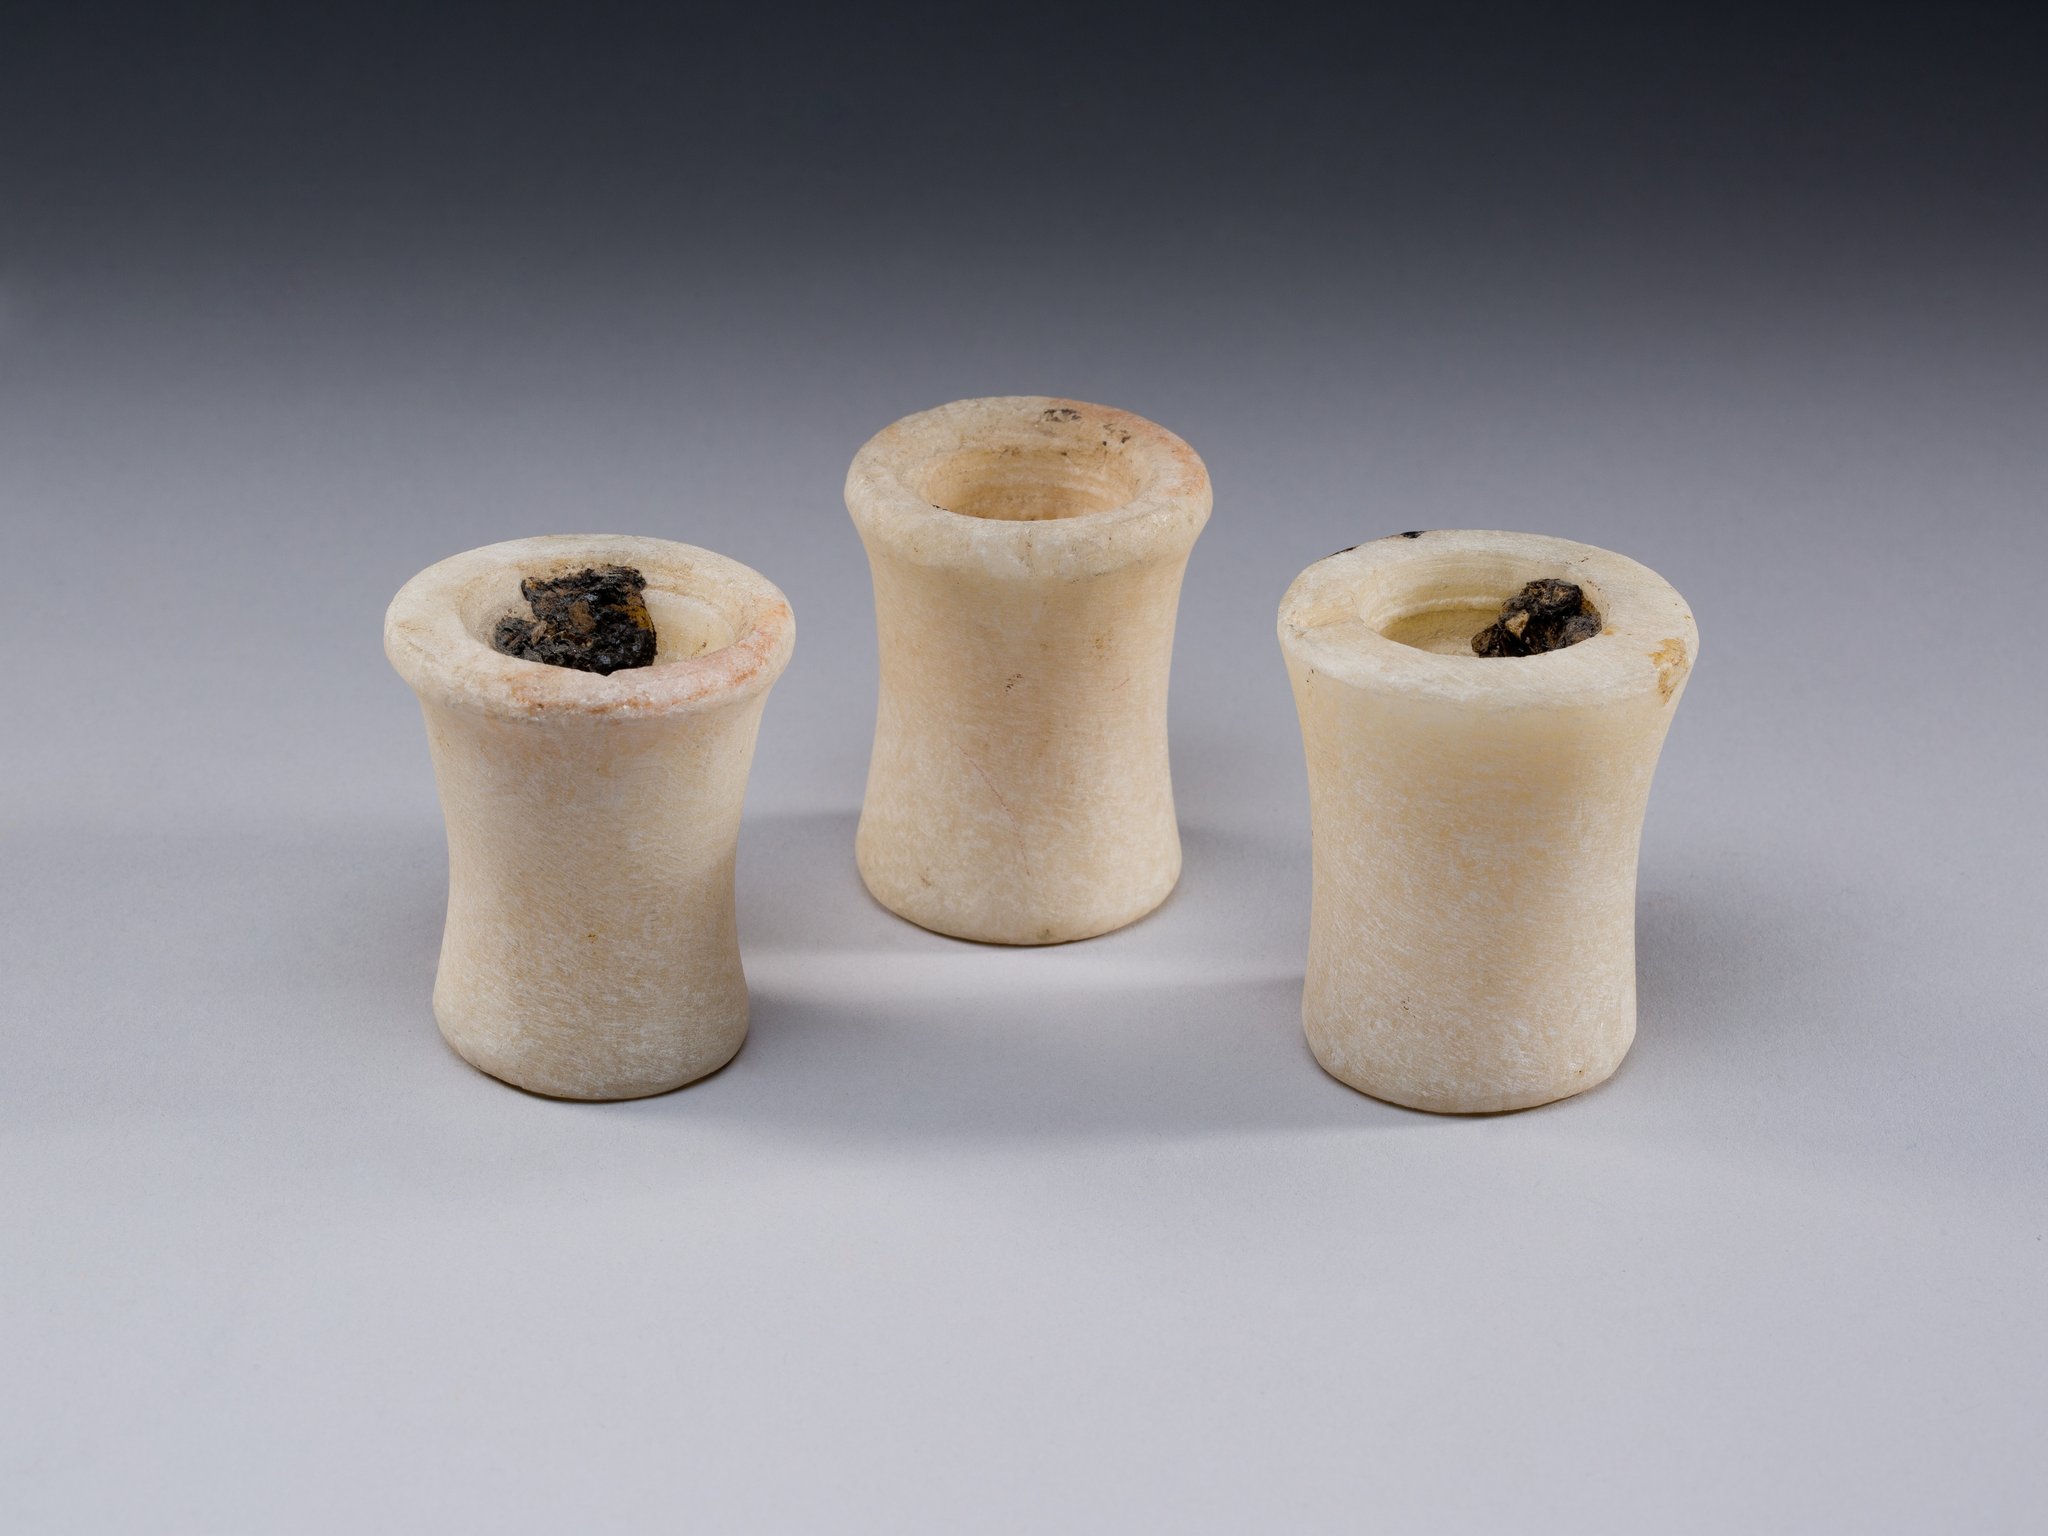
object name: ointment jar, model, senenmut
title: Model Ointment Jar from a Foundation Deposit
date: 1479-1458 BCE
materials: stone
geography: egypt